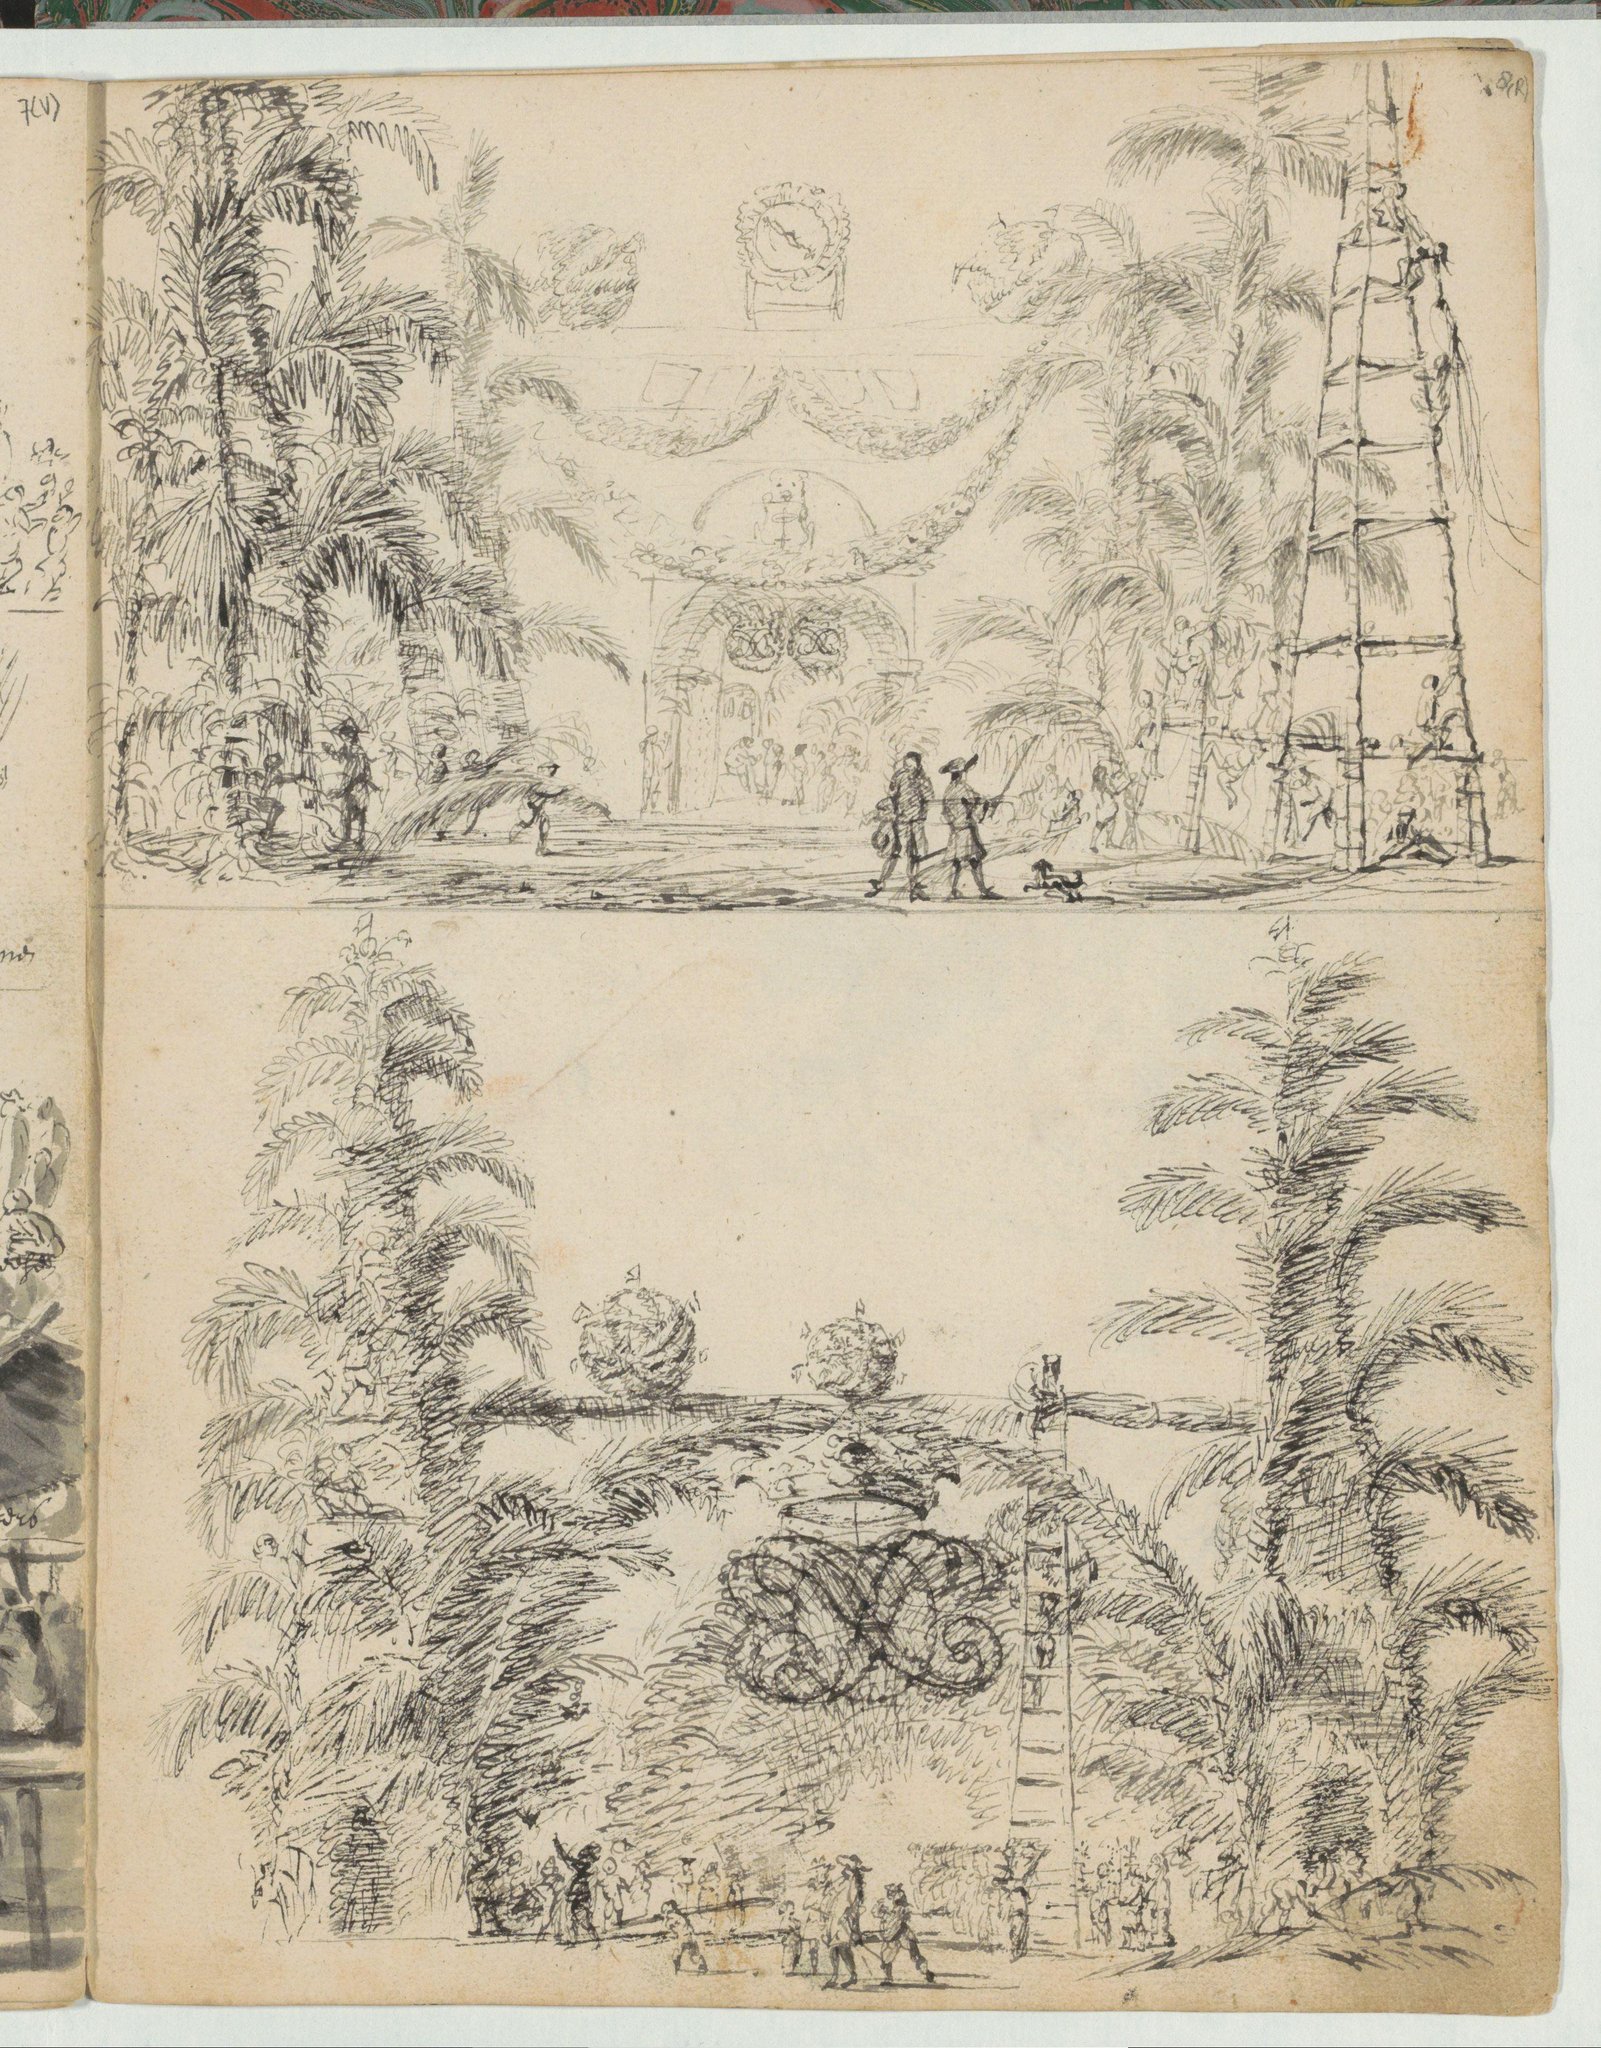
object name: sketchbook leaf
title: Figuren bij een versierde poort omringd door palmbomen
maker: wouter schouten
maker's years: 1638-1704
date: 1664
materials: ink, paper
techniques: pen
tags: garland, wreath, gate, entrance, trees: palm-tree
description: De poort, die mogelijk toegang biedt tot een stad of dorp, is versierd met guirlandes en bloemen. Naast de poort staan bouwwerken (vermoedelijk een soort steigers) opgesteld. Blad 8 recto van een katern van 10 bladen afkomstig uit een schetsboek.